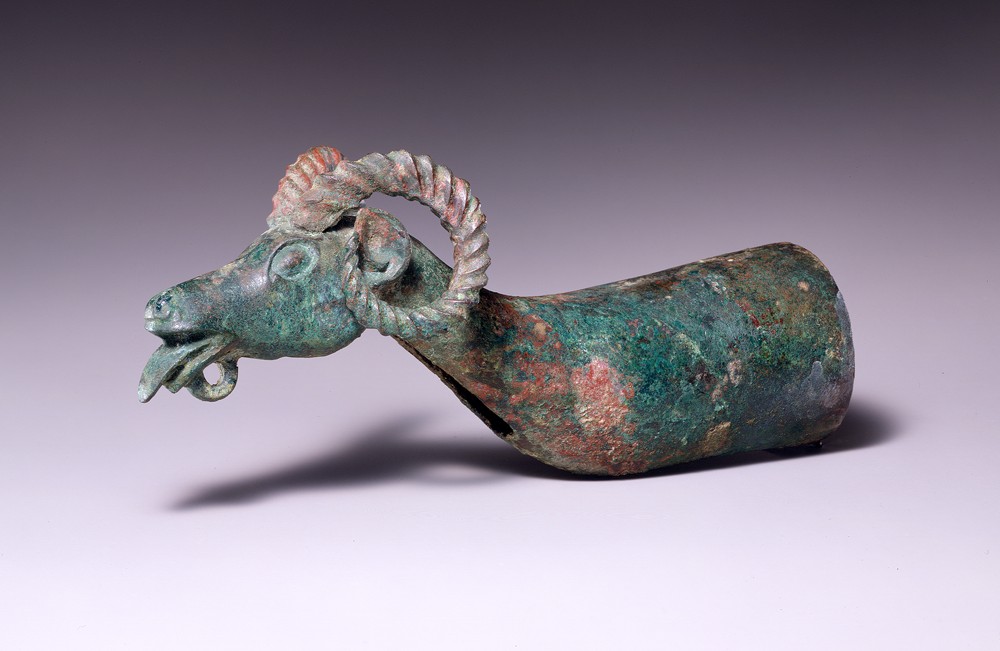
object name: chariot pole ornament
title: Chariot Pole Ornament with Ram's Head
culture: northwest chinese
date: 400-301 BCE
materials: bronze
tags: rams